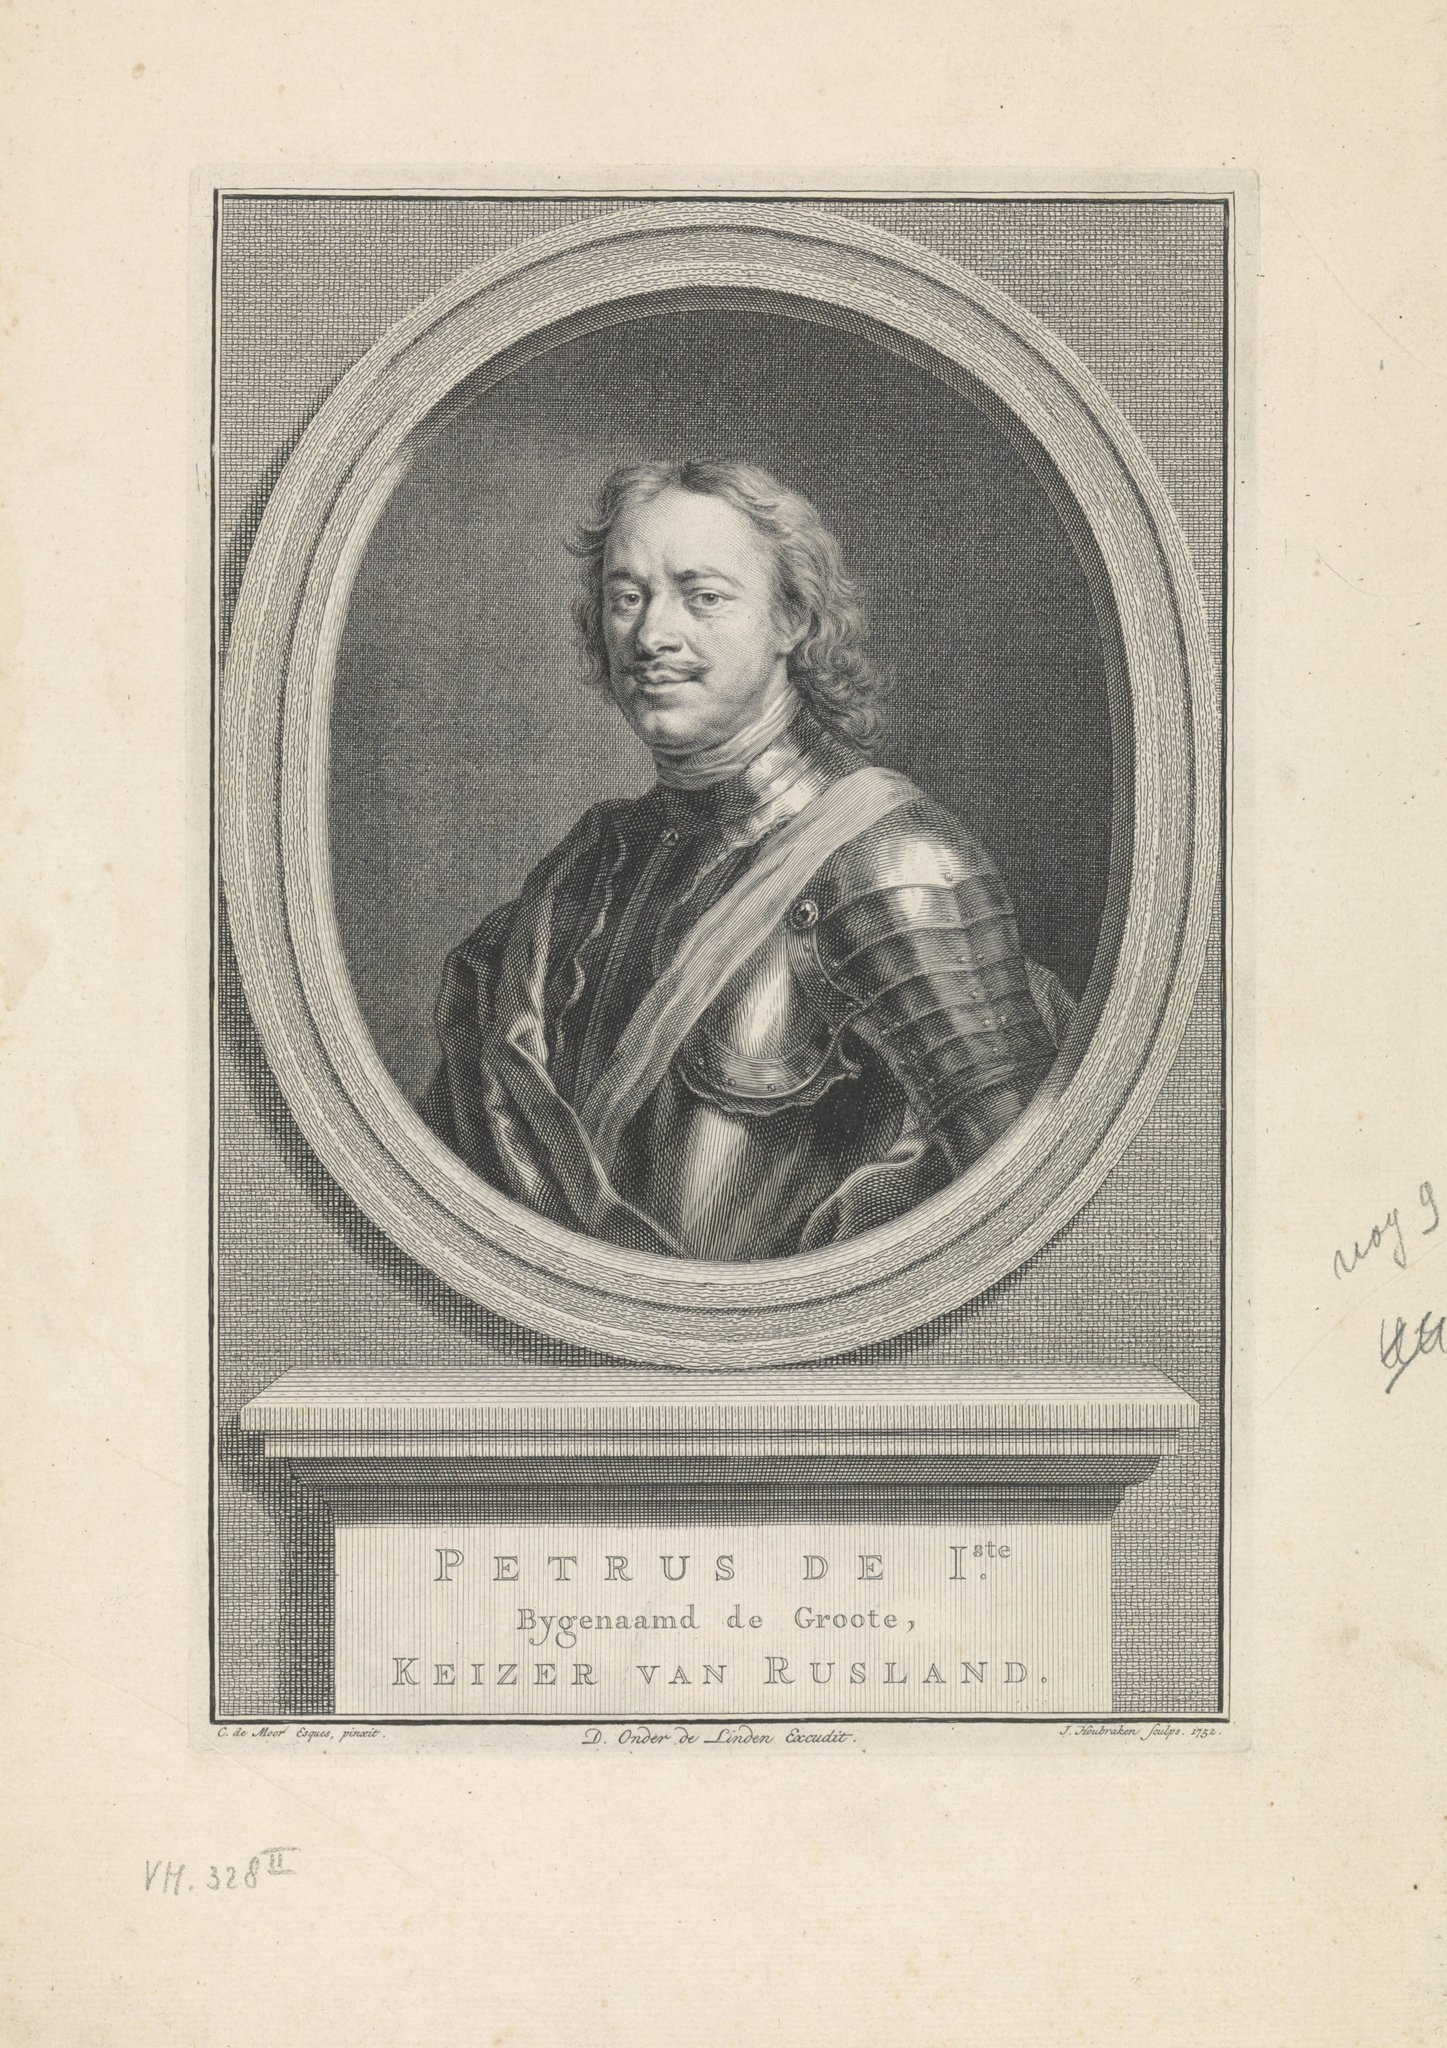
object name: print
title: Portret van Peter I de Grote, tsaar van Rusland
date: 1752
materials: paper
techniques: engraving, etching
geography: amsterdam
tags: peter i de grote (tsaar van rusland), historical persons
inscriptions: collector's mark: Lugt 2228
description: Portret ten halven lijve naar links van Peter I de Grote, tsaar van Rusland in een ovaal. Het portret rust op een piëdestal waarop zijn naam en gegevens in drie regels in het Nederlands.